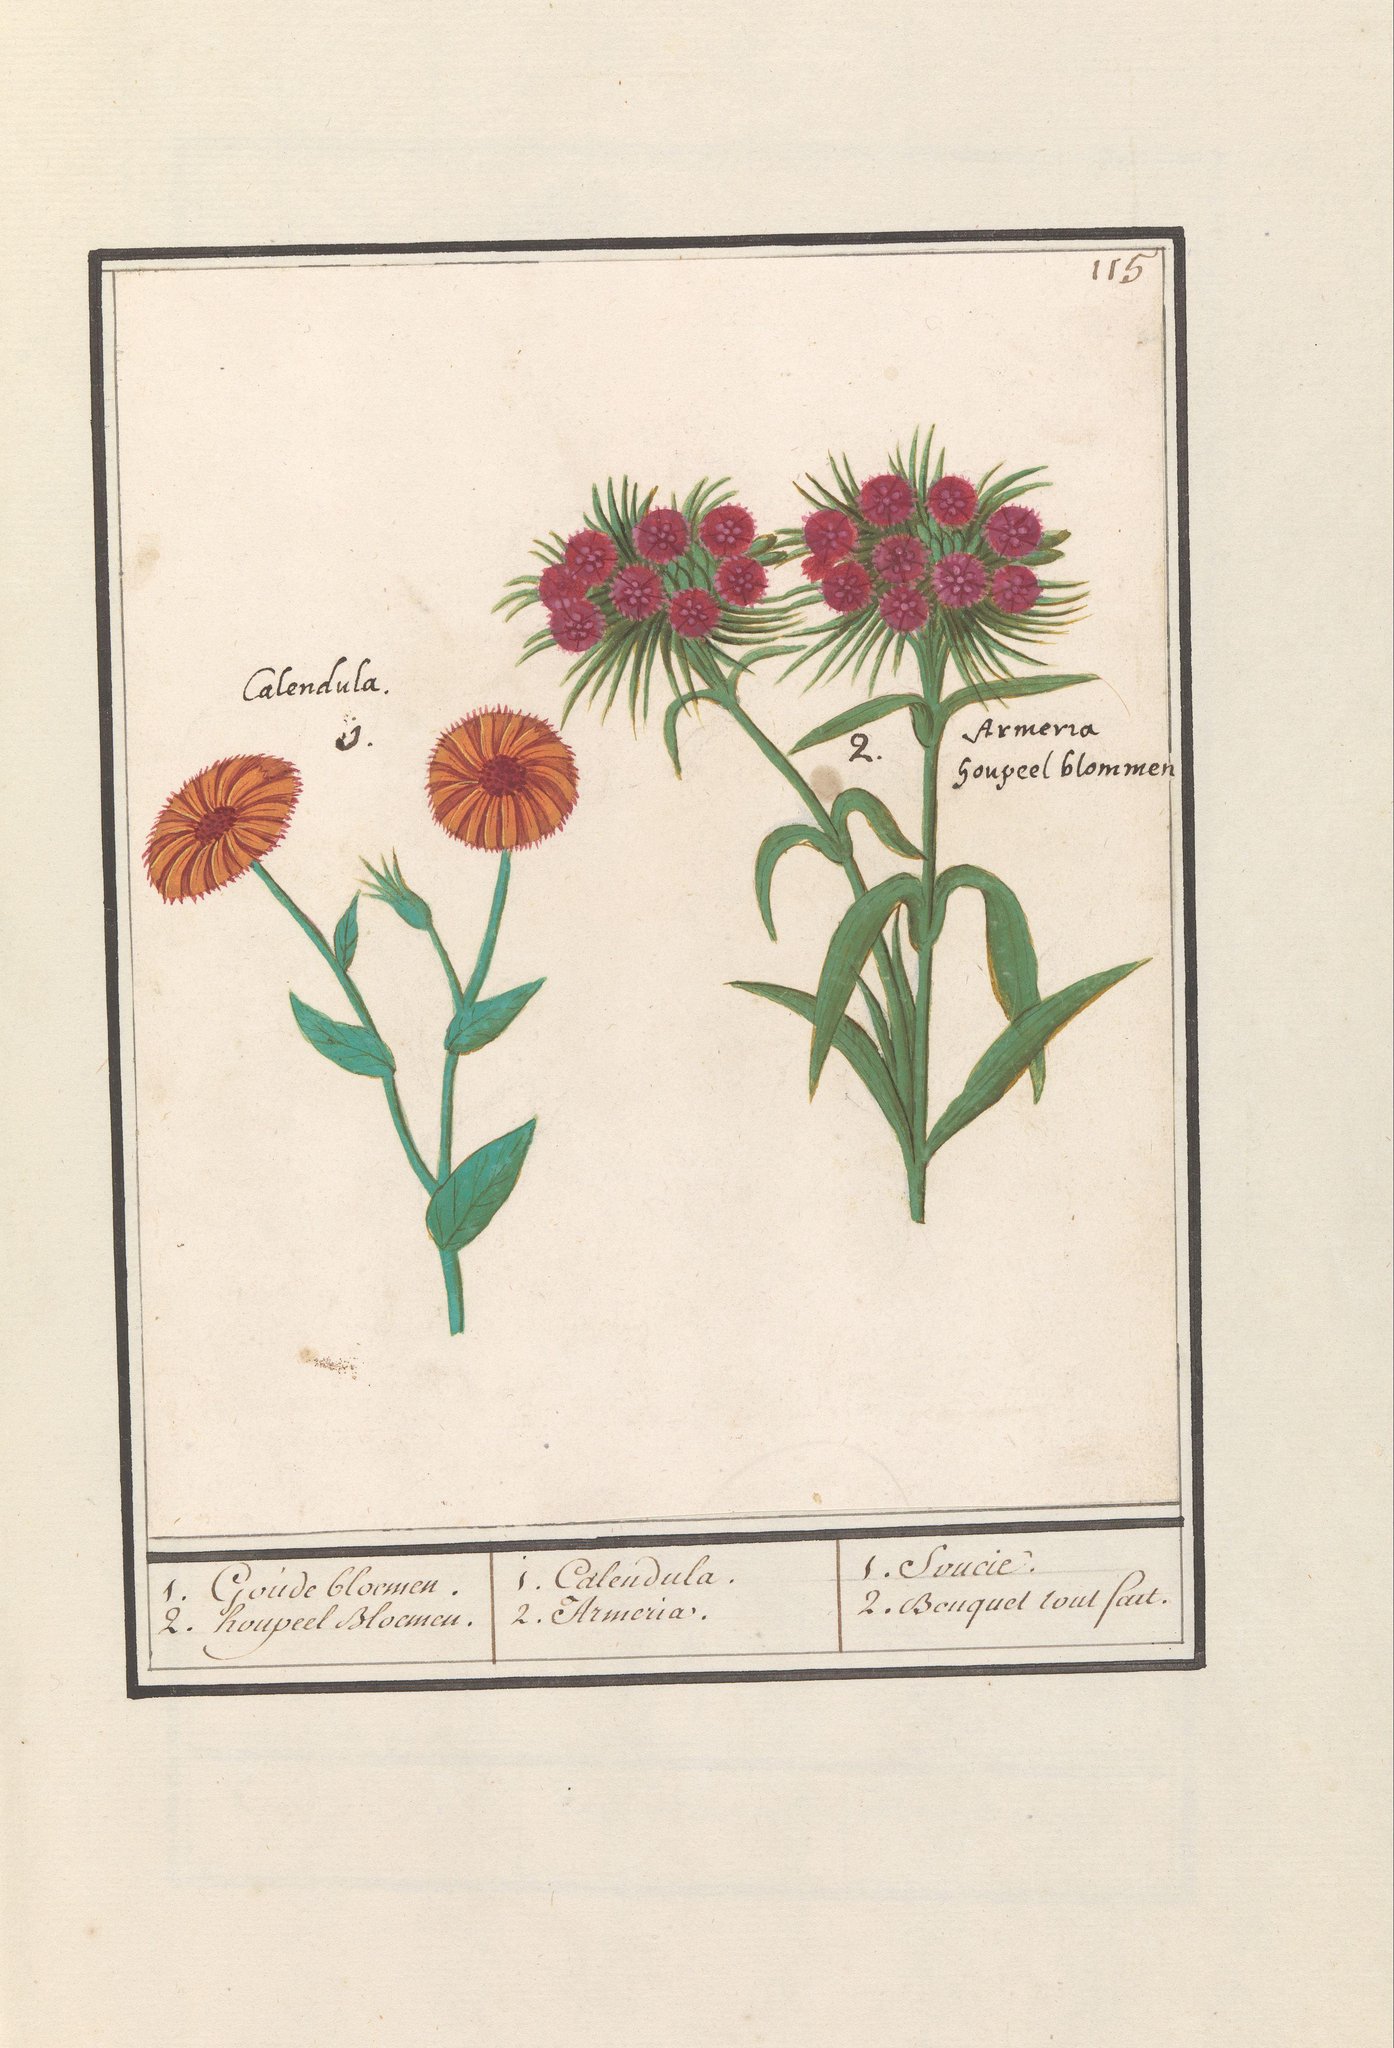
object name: drawing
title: Goudsbloem (Calendula) en Duizendschoon (Dianthus barbatus)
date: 1596-1610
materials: paint, ink, paper, watercolor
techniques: brush, pen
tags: flowers: sweet william, flowers: calendula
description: Goudsbloem en Duizendschoon. Rechtsboven genummerd: 115. Met de Latijnse namen. Onderdeel van het tweede album met tekeningen van bloemen en planten. Negende van twaalf albums met tekeningen van dieren, vogels en planten bekend rond 1600, gemaakt in opdracht van keizer Rudolf II. Met toelichting in Nederlands, Latijn en Frans.